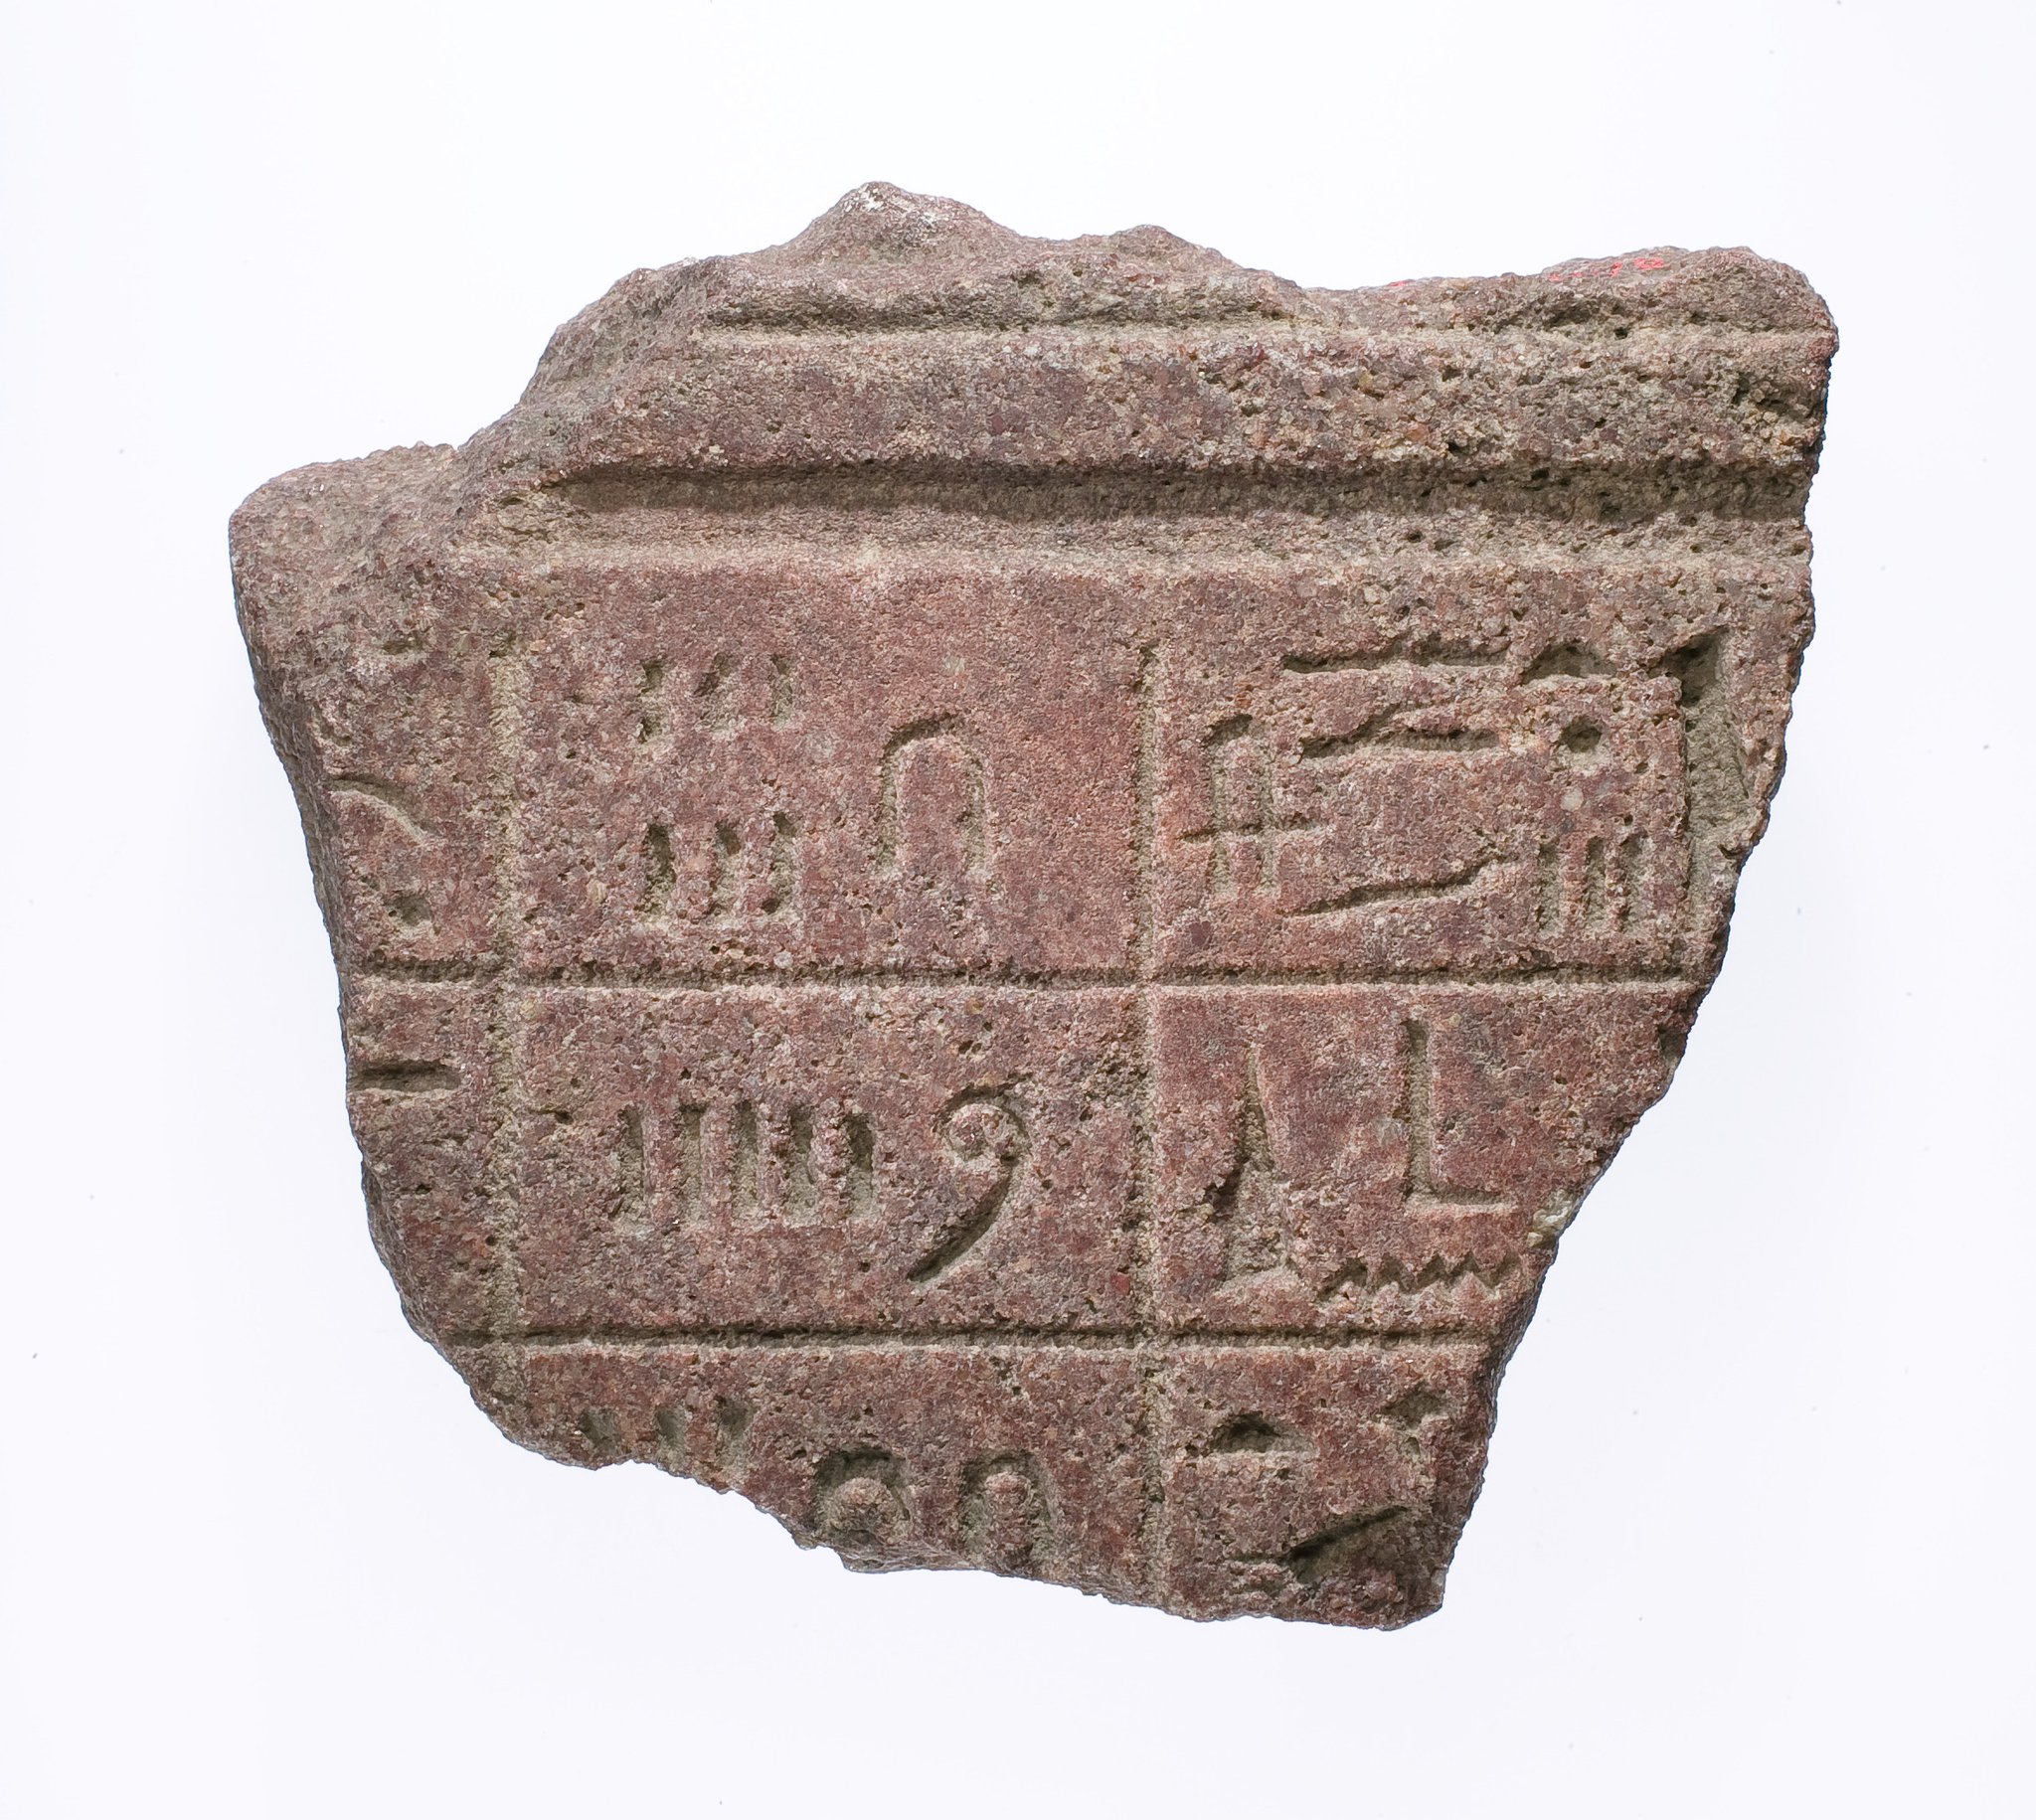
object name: offering list stela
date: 1353-1336 BCE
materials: quartzite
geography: egypt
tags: hieroglyphs